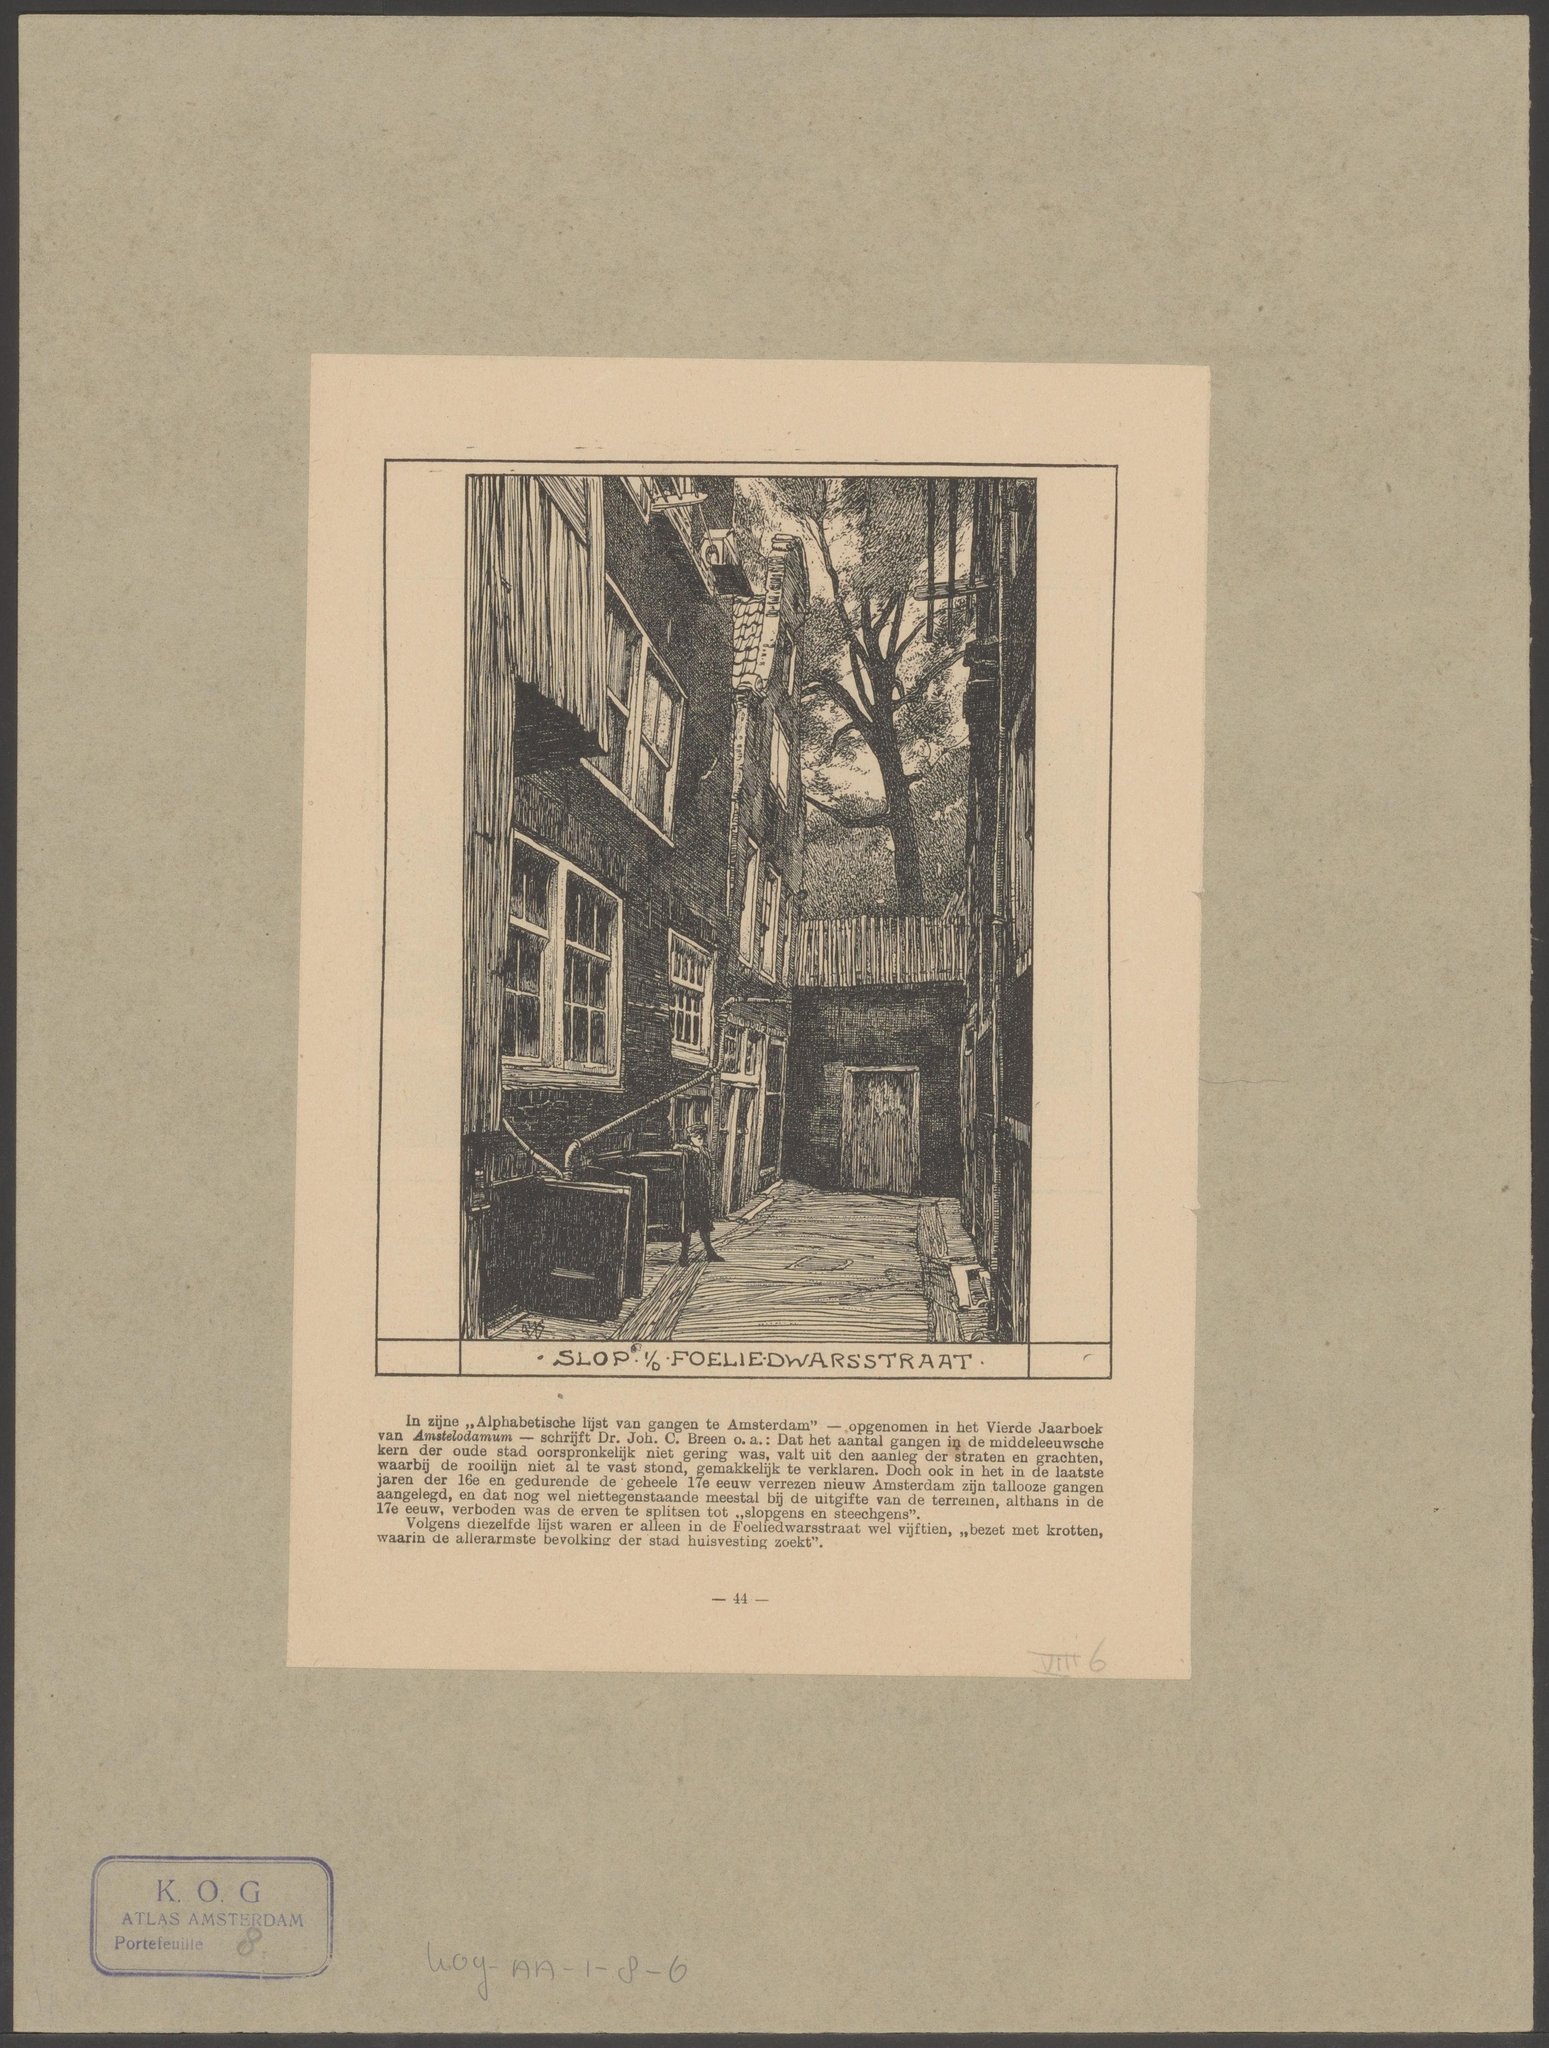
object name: page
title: Gezicht op de Foeliedwarsstraat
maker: willem wenckebach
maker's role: designer, draughtsman, painter, print maker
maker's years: 1860-1937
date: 1870-1923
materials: paper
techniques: letterpress printing, line block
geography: amsterdam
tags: city-view in general; 'veduta', the usual house or row of houses, lane, alley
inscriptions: collector's mark: ‘8’ Lugt 1641b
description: Onderwerpsrubriek binnen de Atlas Amsterdam: Egelantiersdwarsstraat, Egelantiersgracht, Elandsgracht, Engelschesteeg, Foeliedwarsstraat, Frederiksplein, Funen.